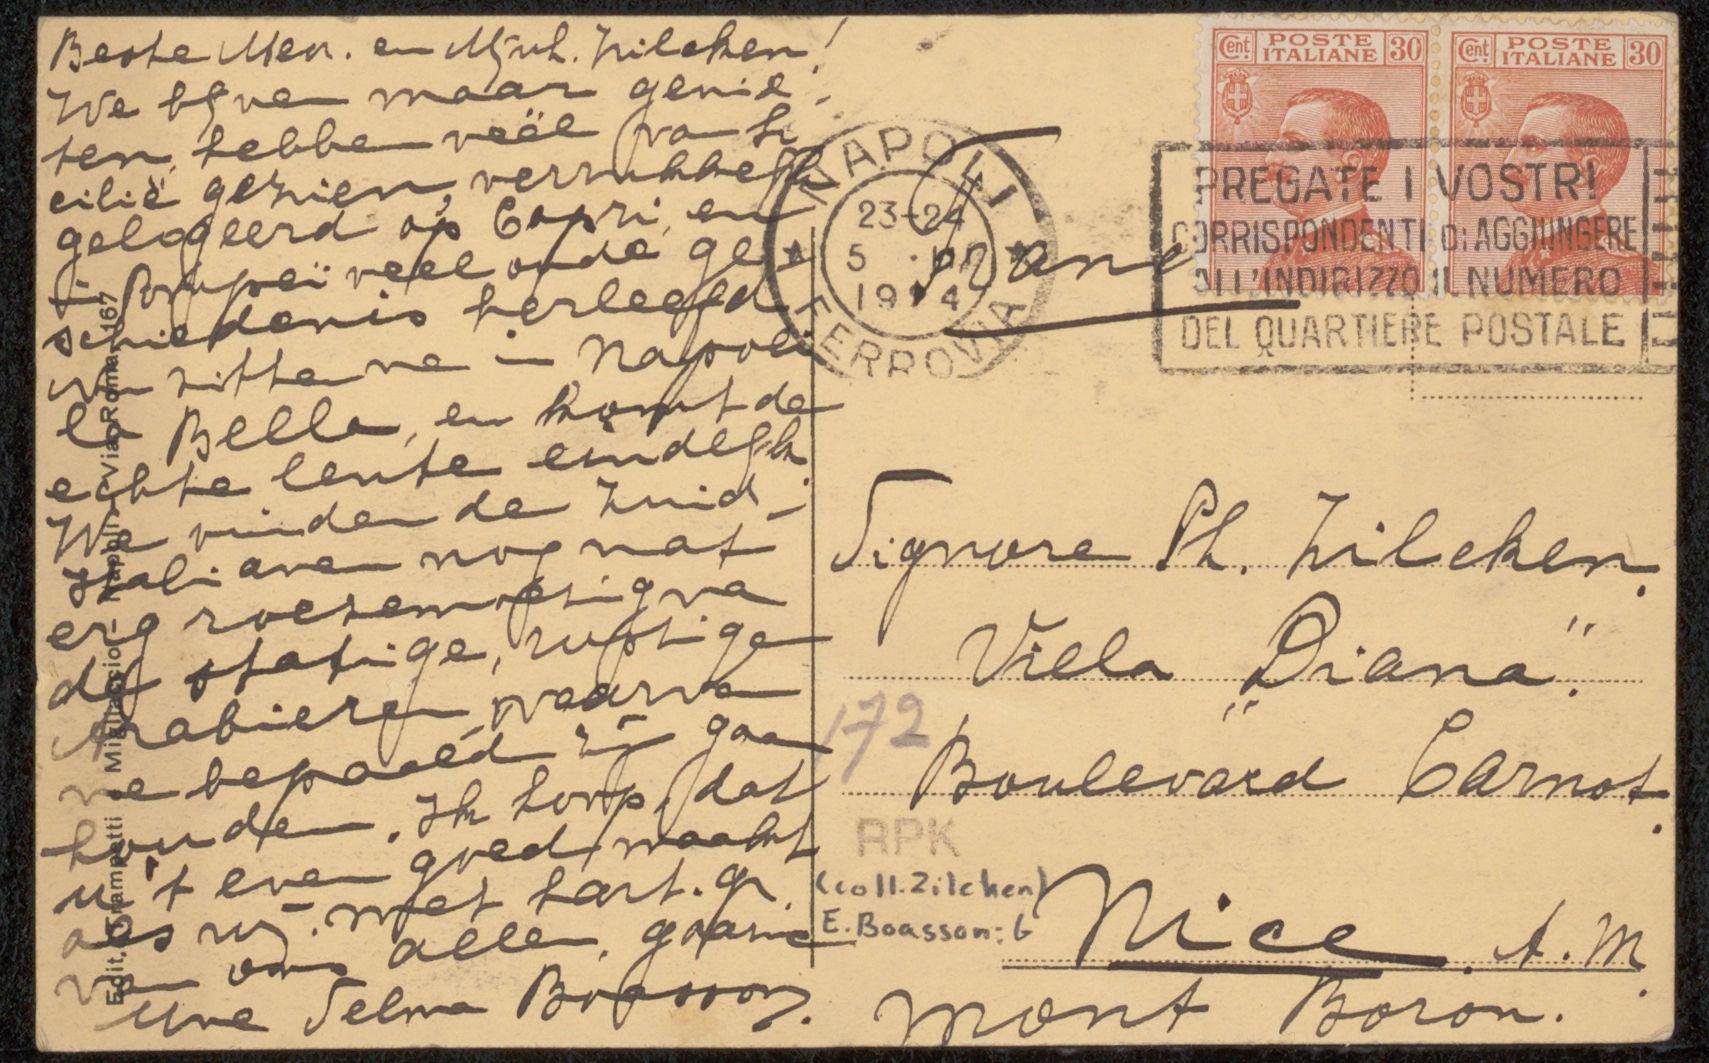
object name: ansichtkaart, prentbriefkaart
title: Prentbriefkaart aan Philip Zilcken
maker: selma boasson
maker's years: 1884-1924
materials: cardboard, ink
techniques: photograph, pen, writing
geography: naples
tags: the hague, painter, philip zilcken, capri, isola di, pompeii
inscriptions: collector's mark: ‘RPK’